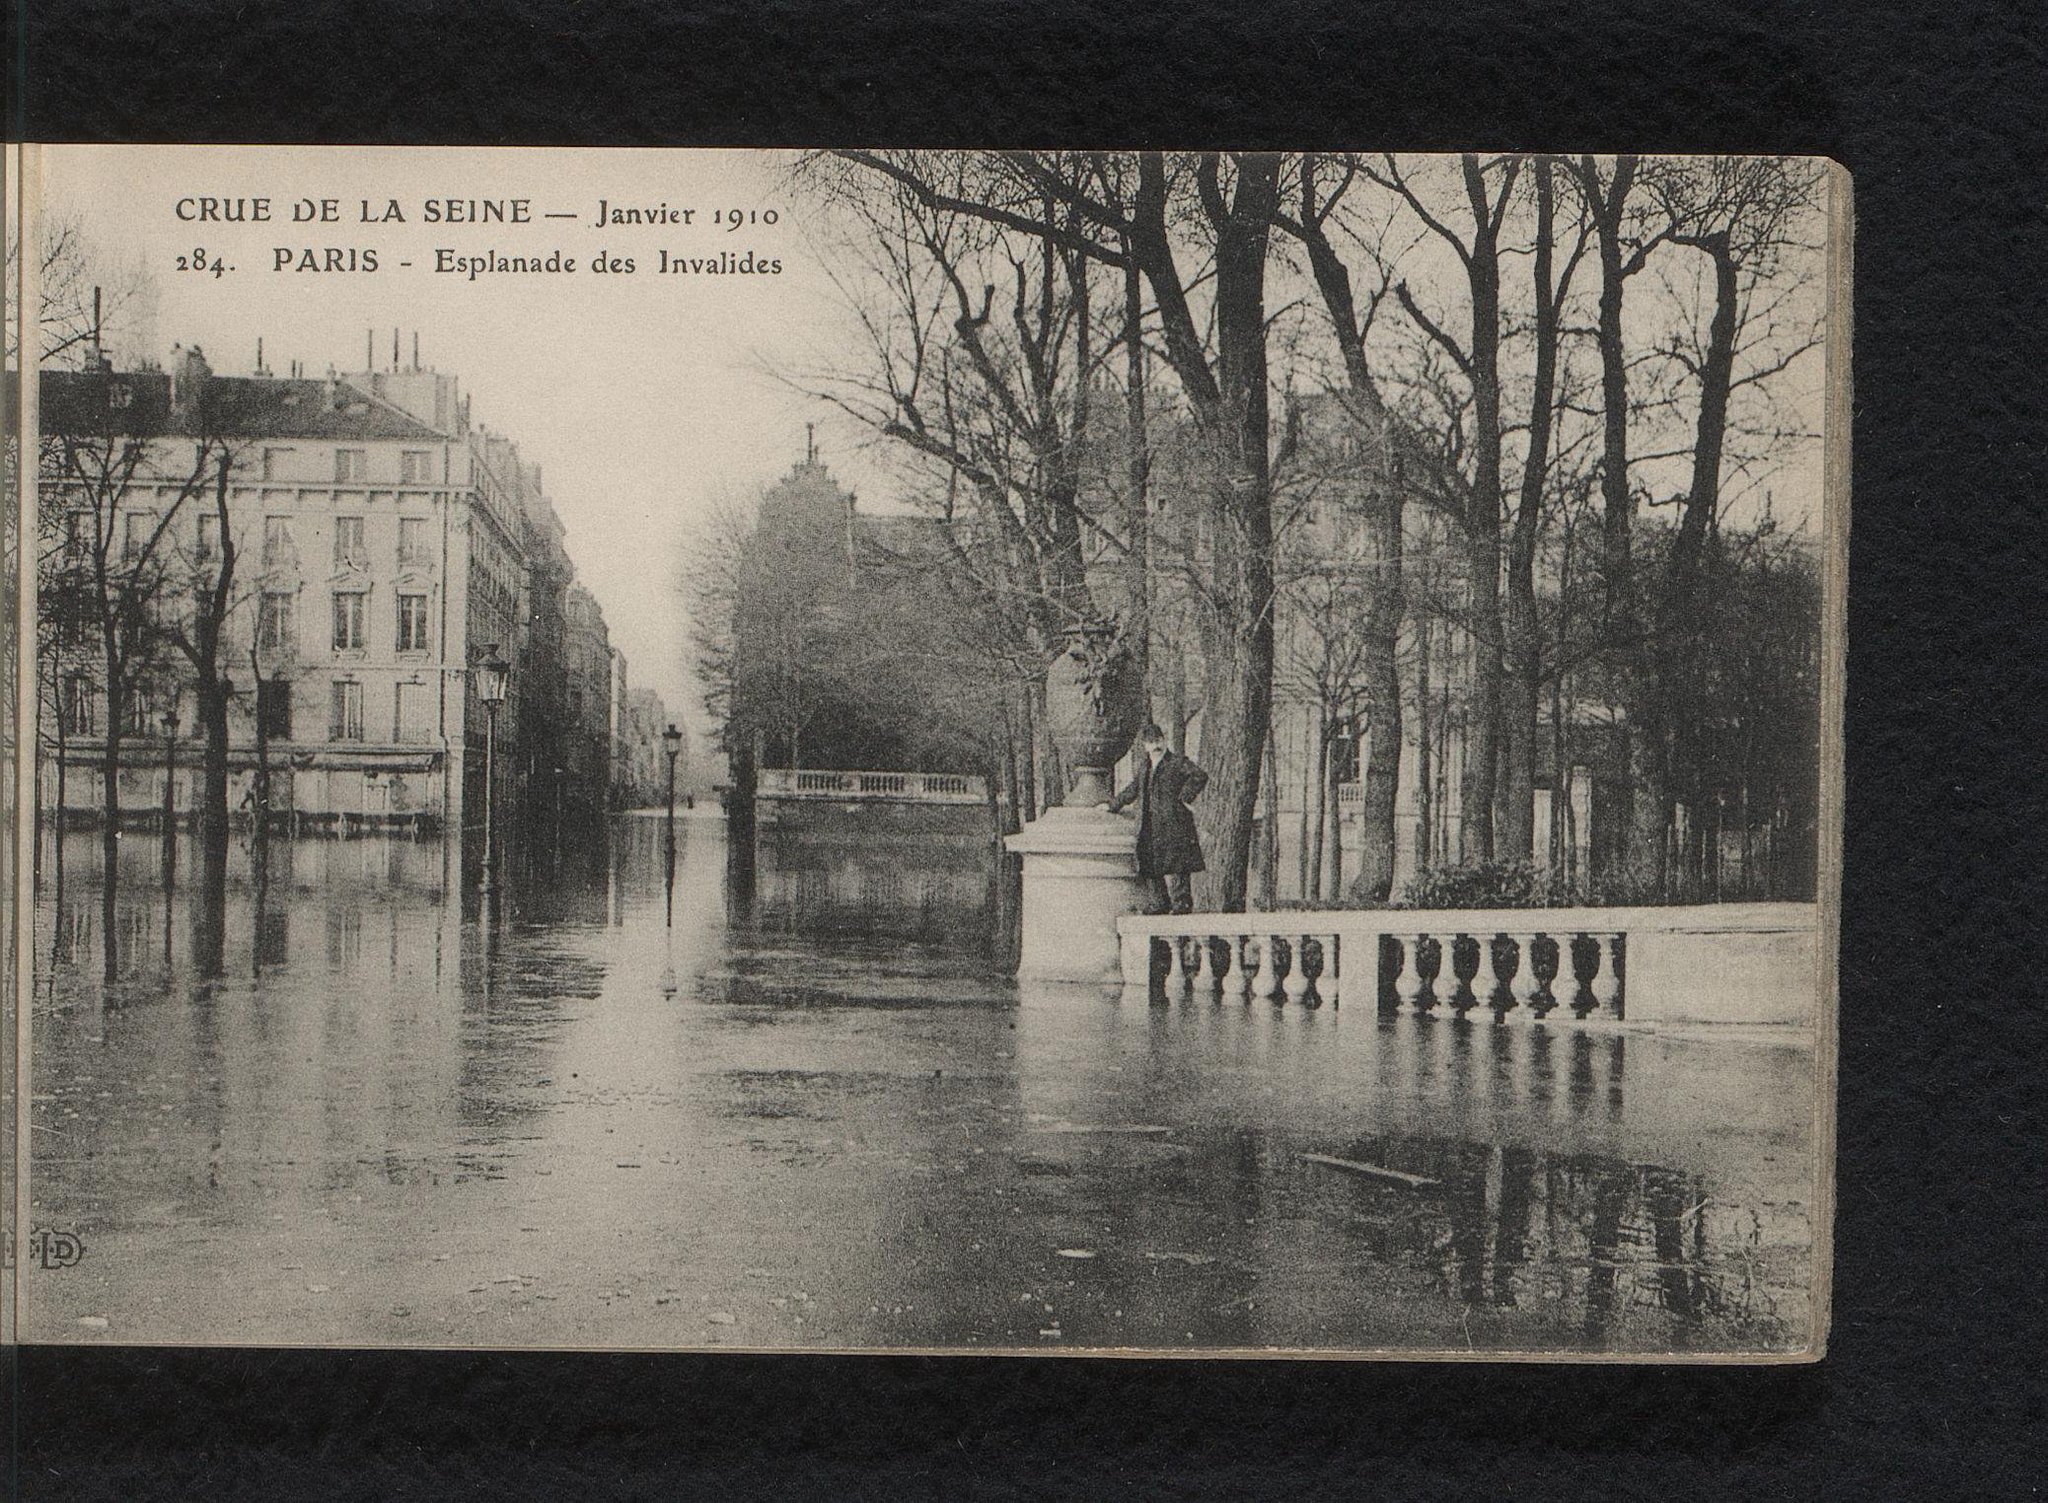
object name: photomechanical print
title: Paris. Esplanade des Invalides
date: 1910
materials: cardboard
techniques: photograph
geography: paris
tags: flood, city-view, and landscape with man-made constructions (+ city(-scape) with figures, staffage), paris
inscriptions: date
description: Prentbriefkaart maakt deel uit van een album.